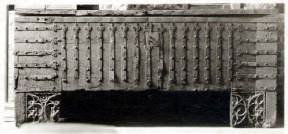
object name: chest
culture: german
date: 1401-1500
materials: iron, wood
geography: germany